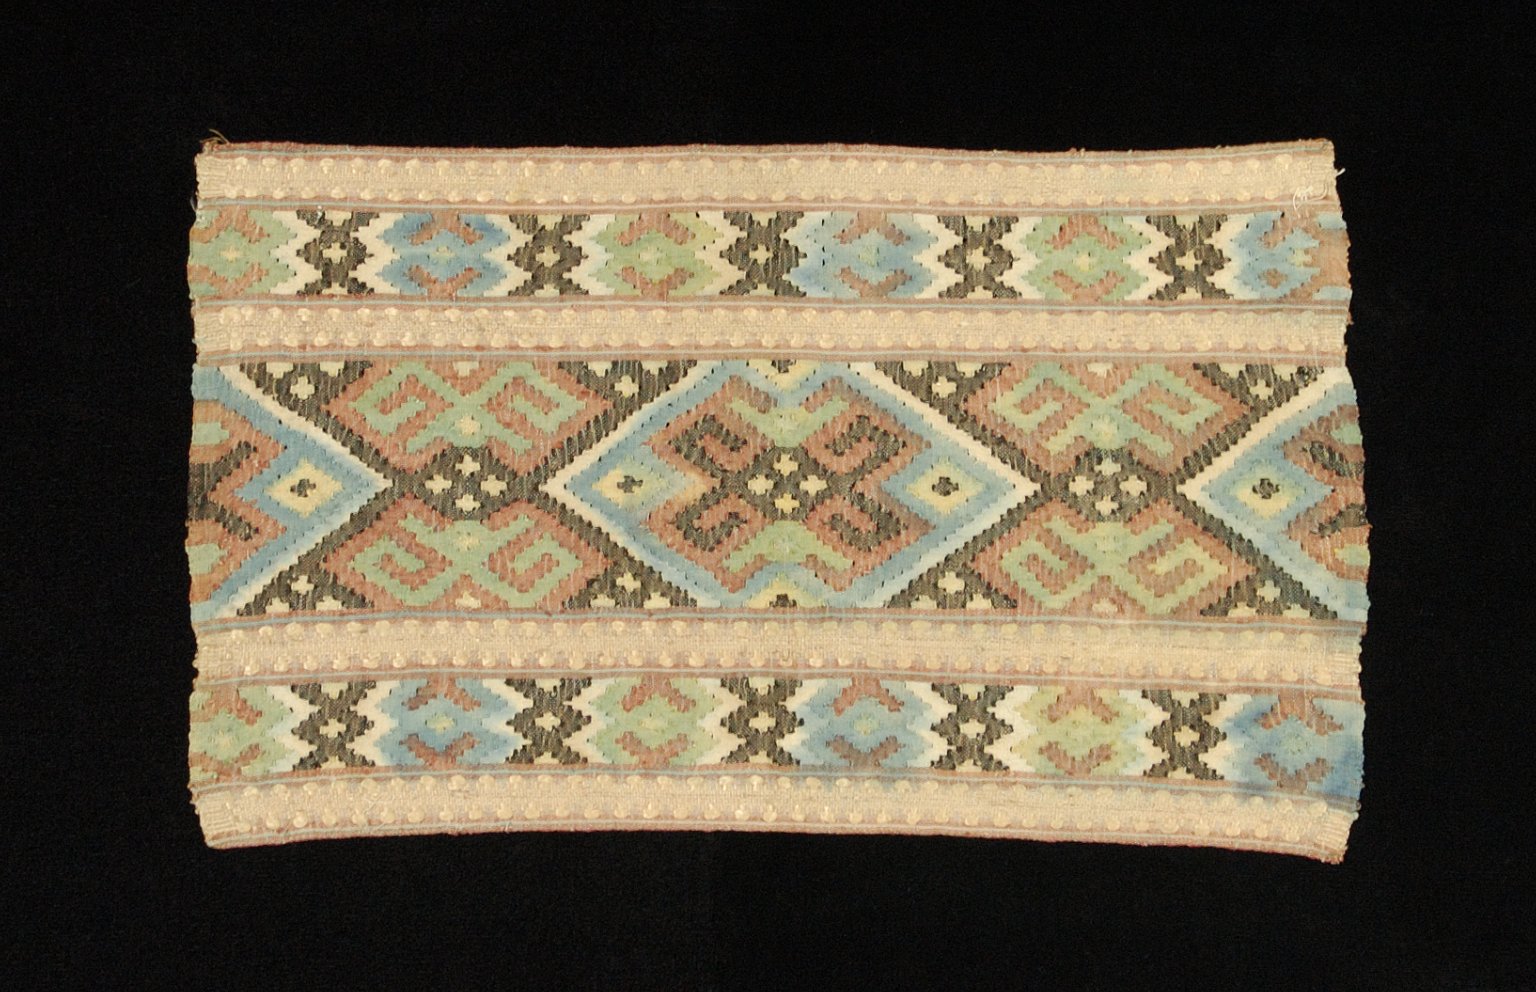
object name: textile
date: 1840-1870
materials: silk